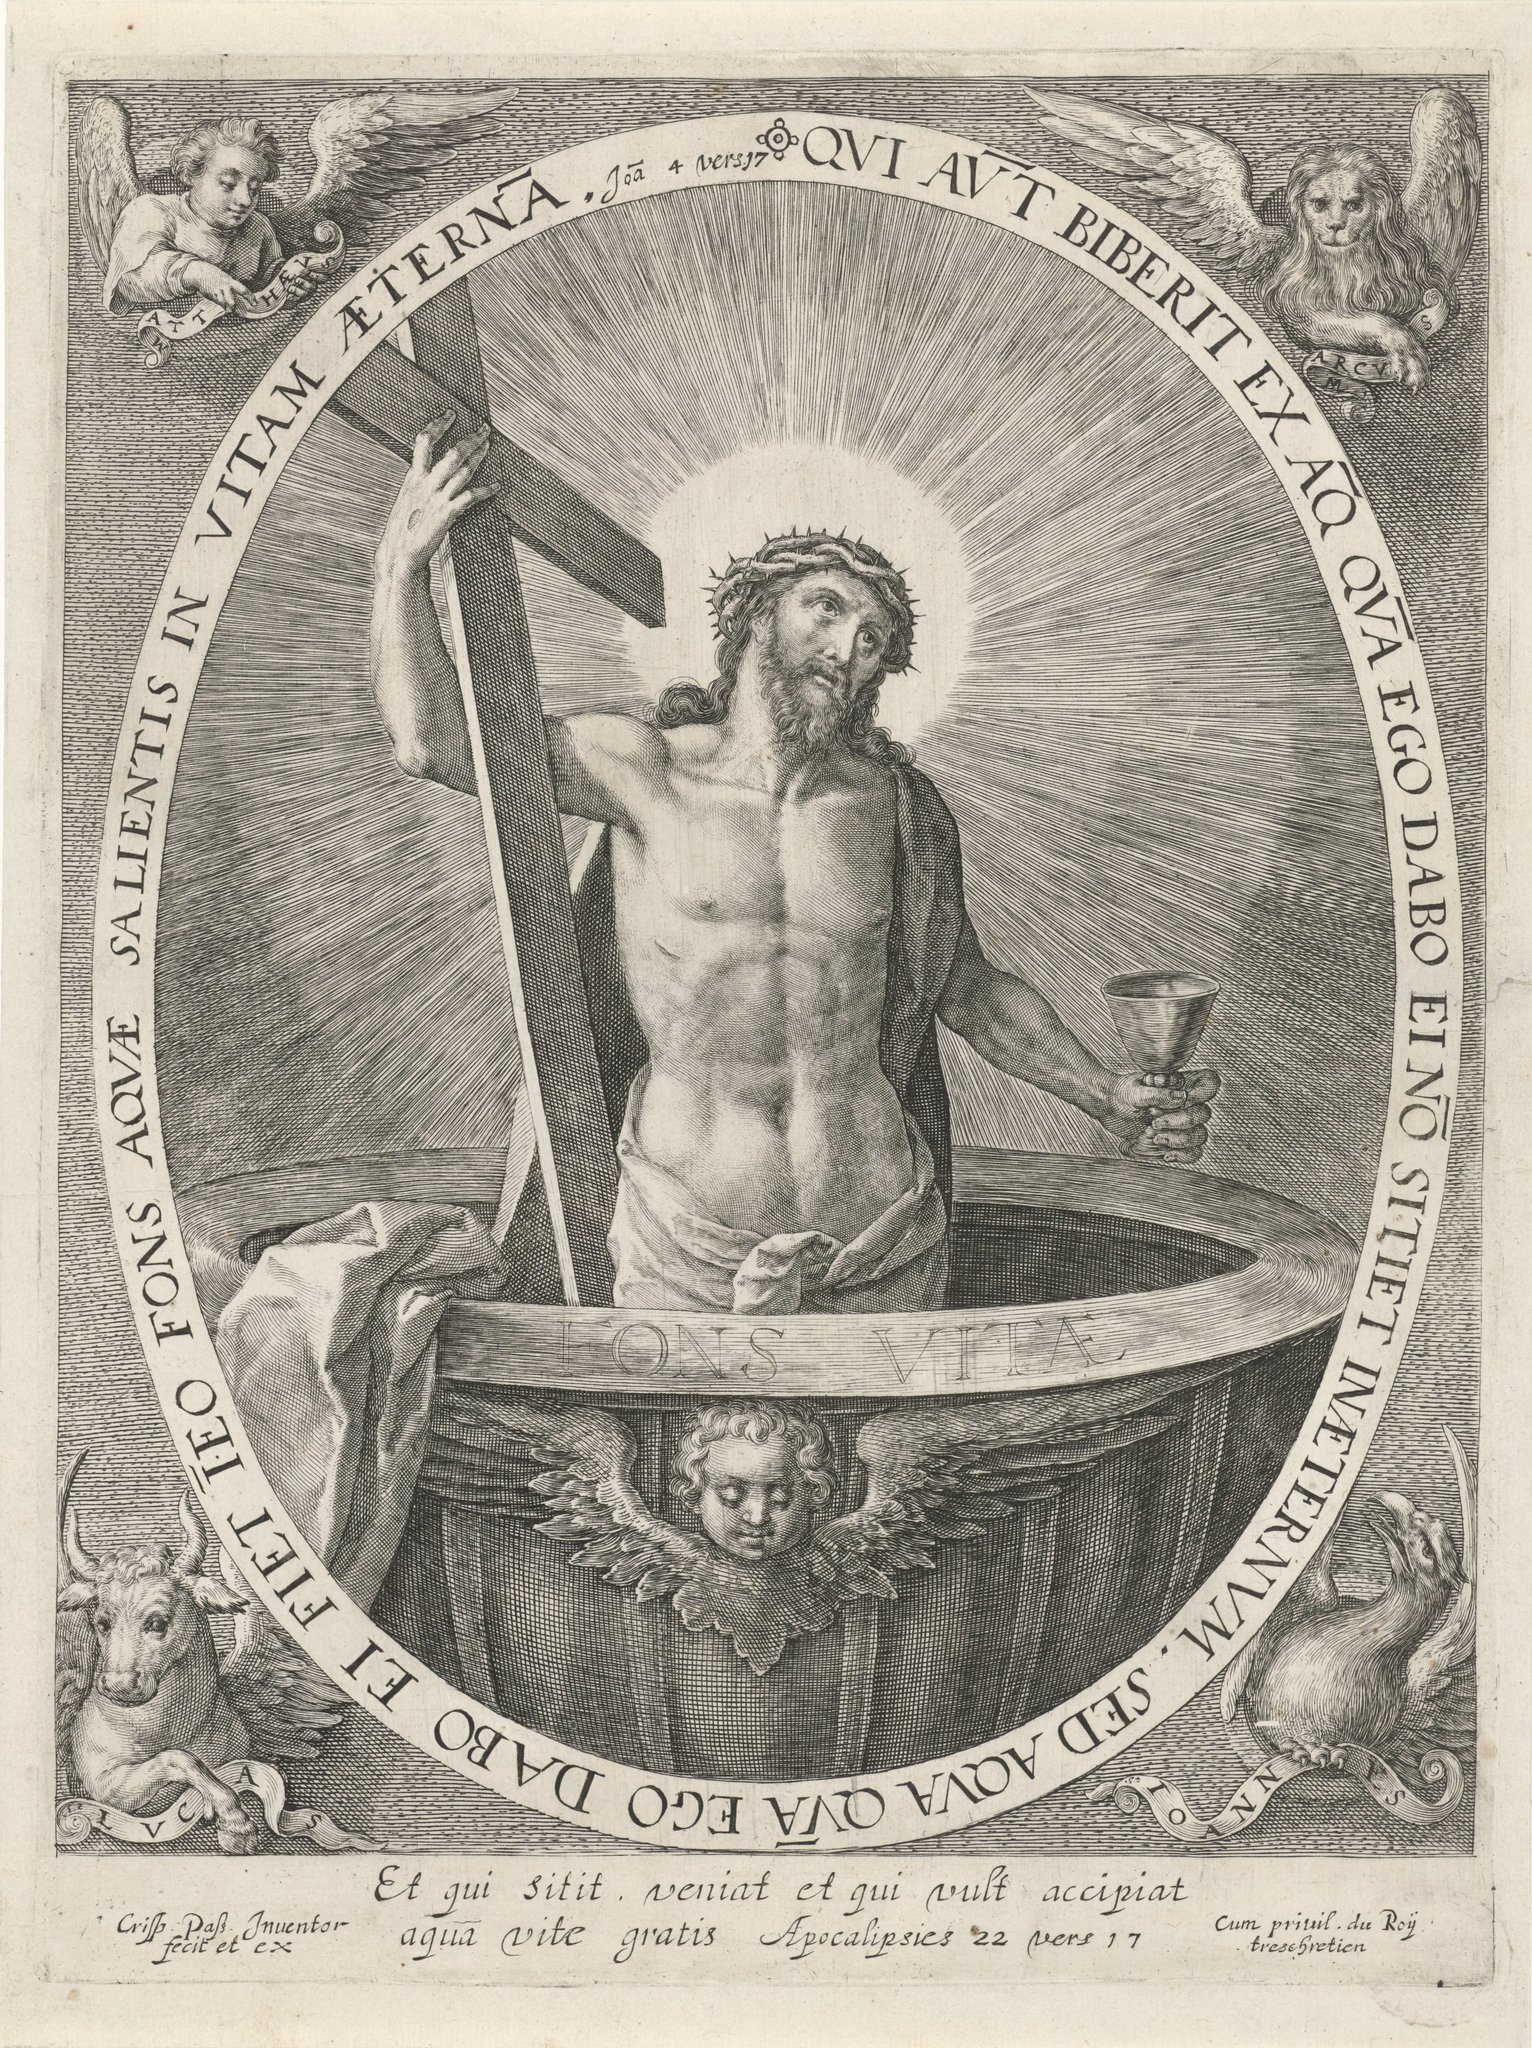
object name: print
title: Fons Vitæ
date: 1574-1637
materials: paper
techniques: engraving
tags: the four symbols of the evangelists, 'the apocalyptic beasts', 'fons vitae', 'fons pietatis'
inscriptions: collector's mark: Lugt 240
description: Christus staat in een waterbekken. Hij draagt de doornenkroon, omarmt het kruis en houdt een kelk vast. De voorstelling is gevat in een ovale omlijsting met een randschrift met een Bijbelcitaat in het Latijn. In de hoeken de symbolen van de vier evangelisten. In de marge een tweeregelig Bijbelcitaat in het Latijn.